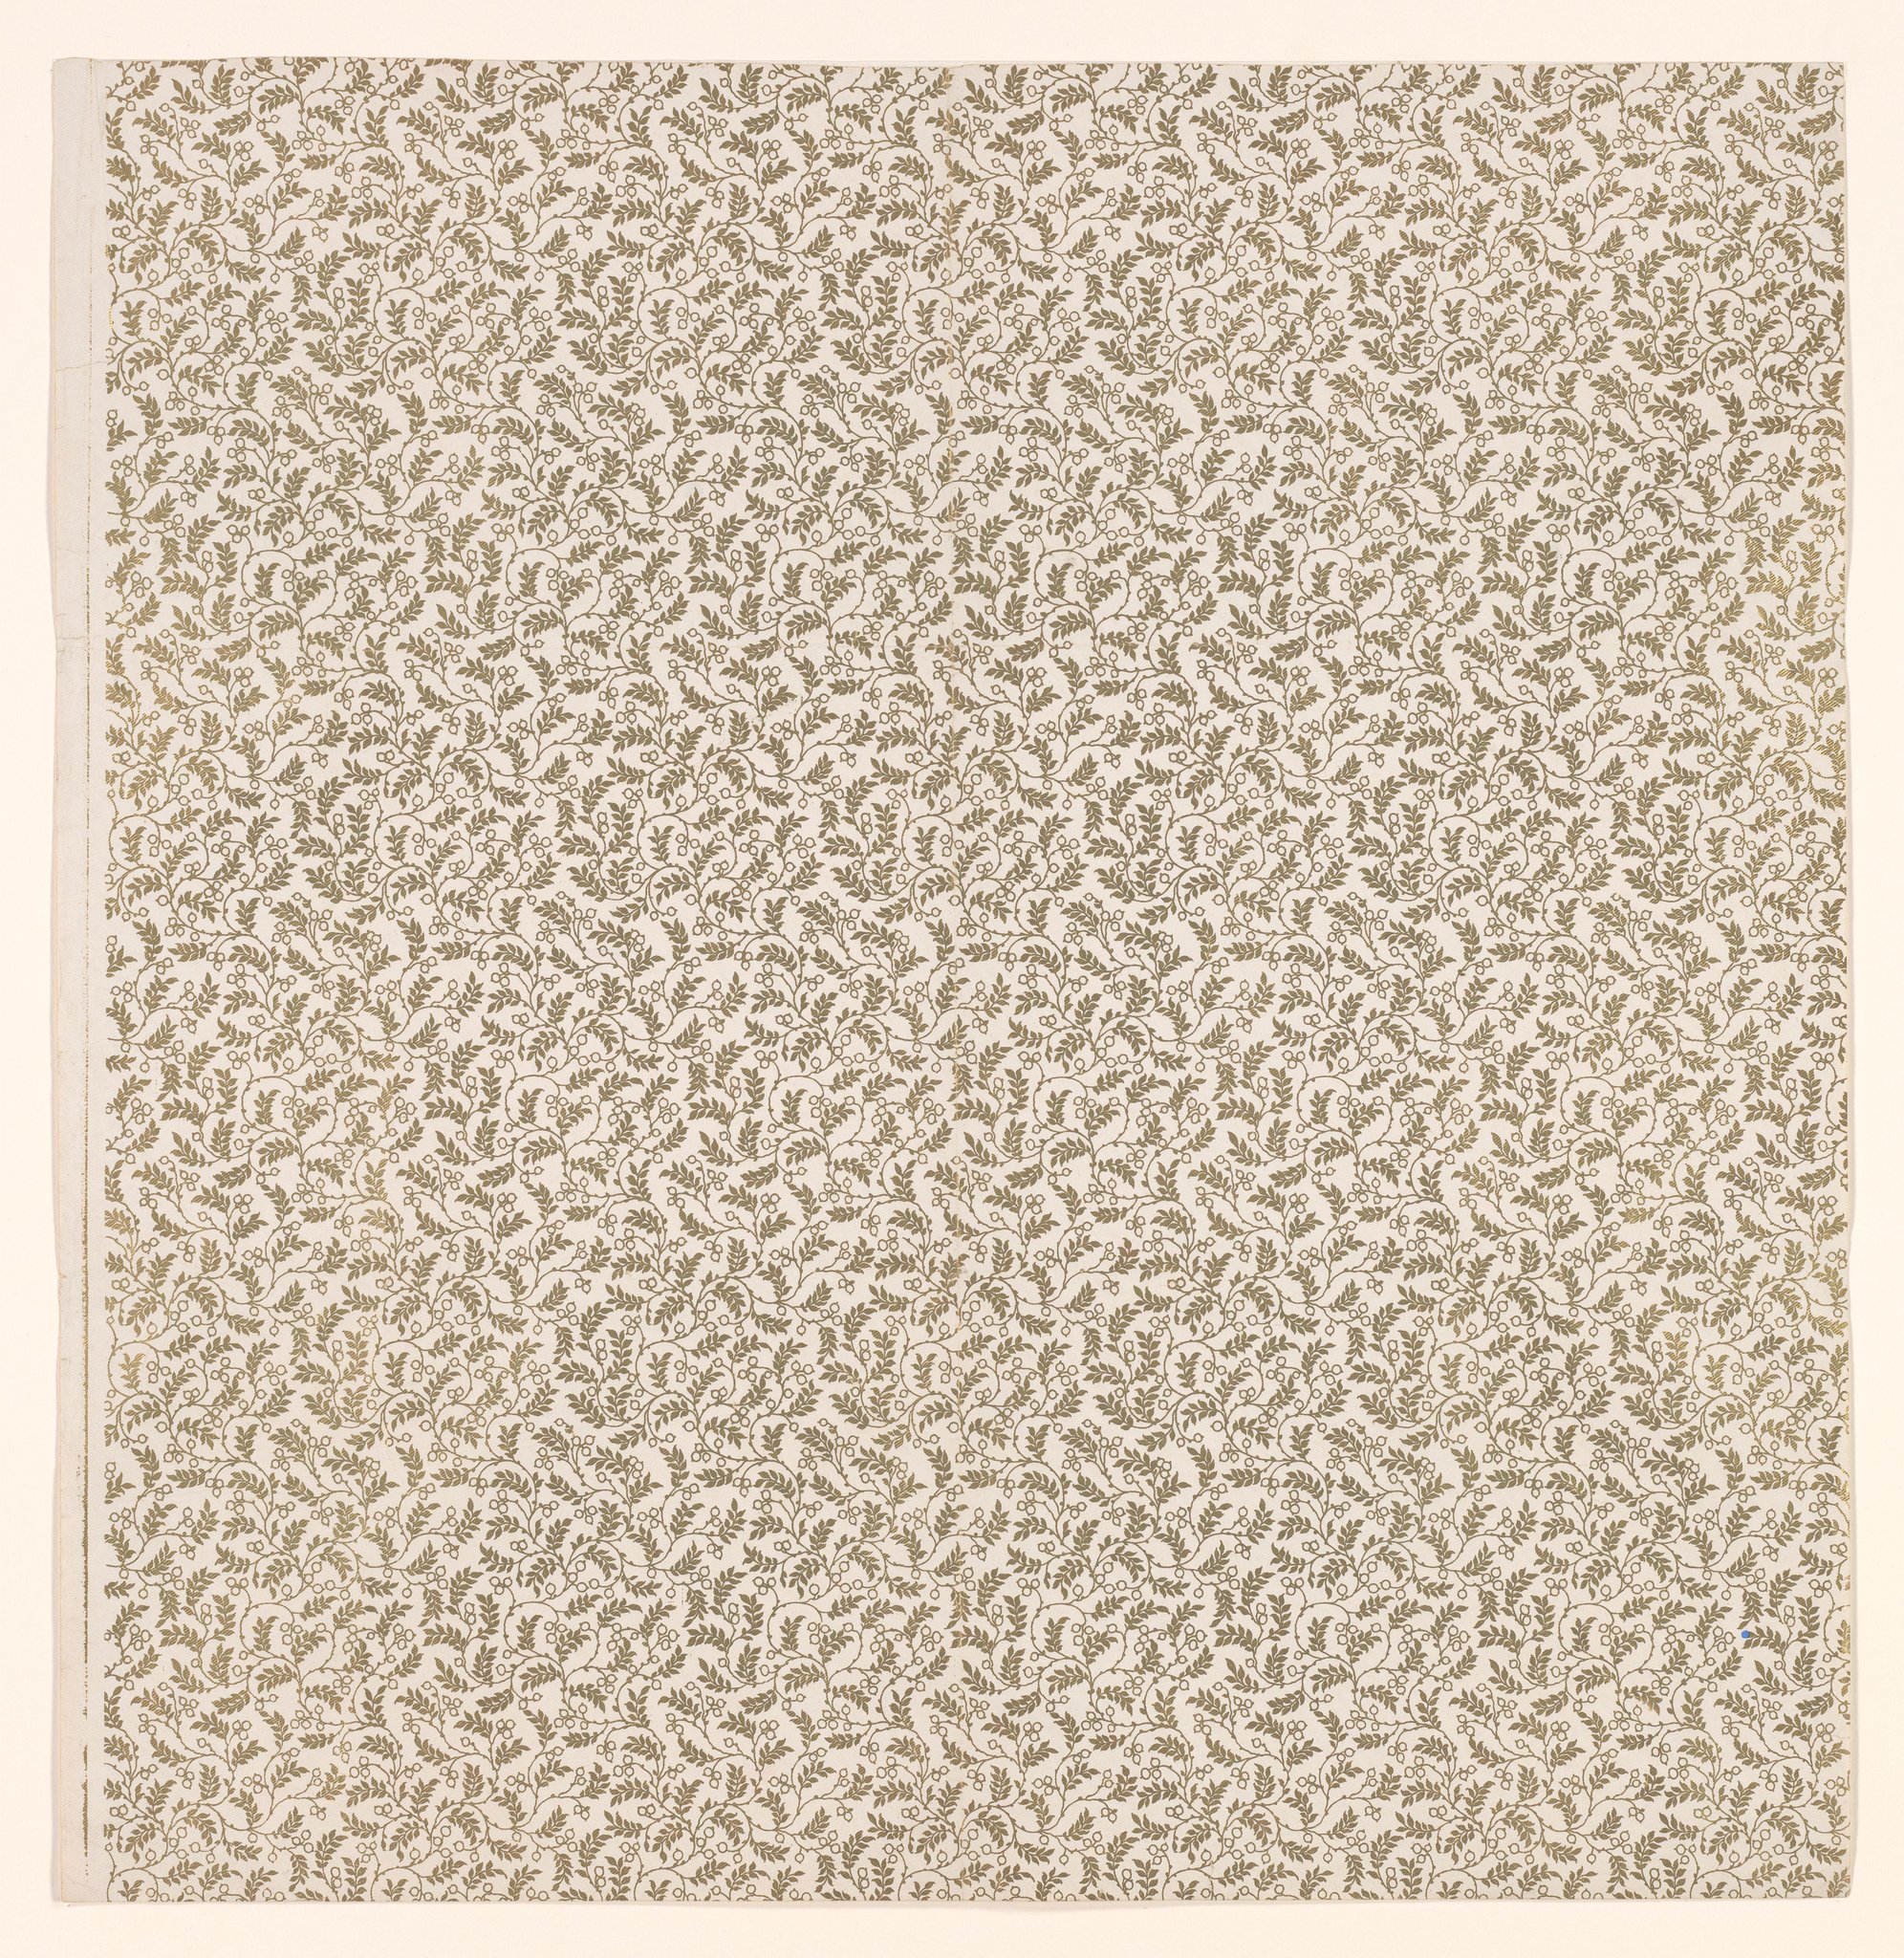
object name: embossed paper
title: Blad met bladeren en vruchten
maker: Anonymous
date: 1850-1950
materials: paint, paper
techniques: gauffering, mechanical printing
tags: ornament derived from plant forms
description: Blad met een patroon van ranken met bladeren en vruchten in goud.